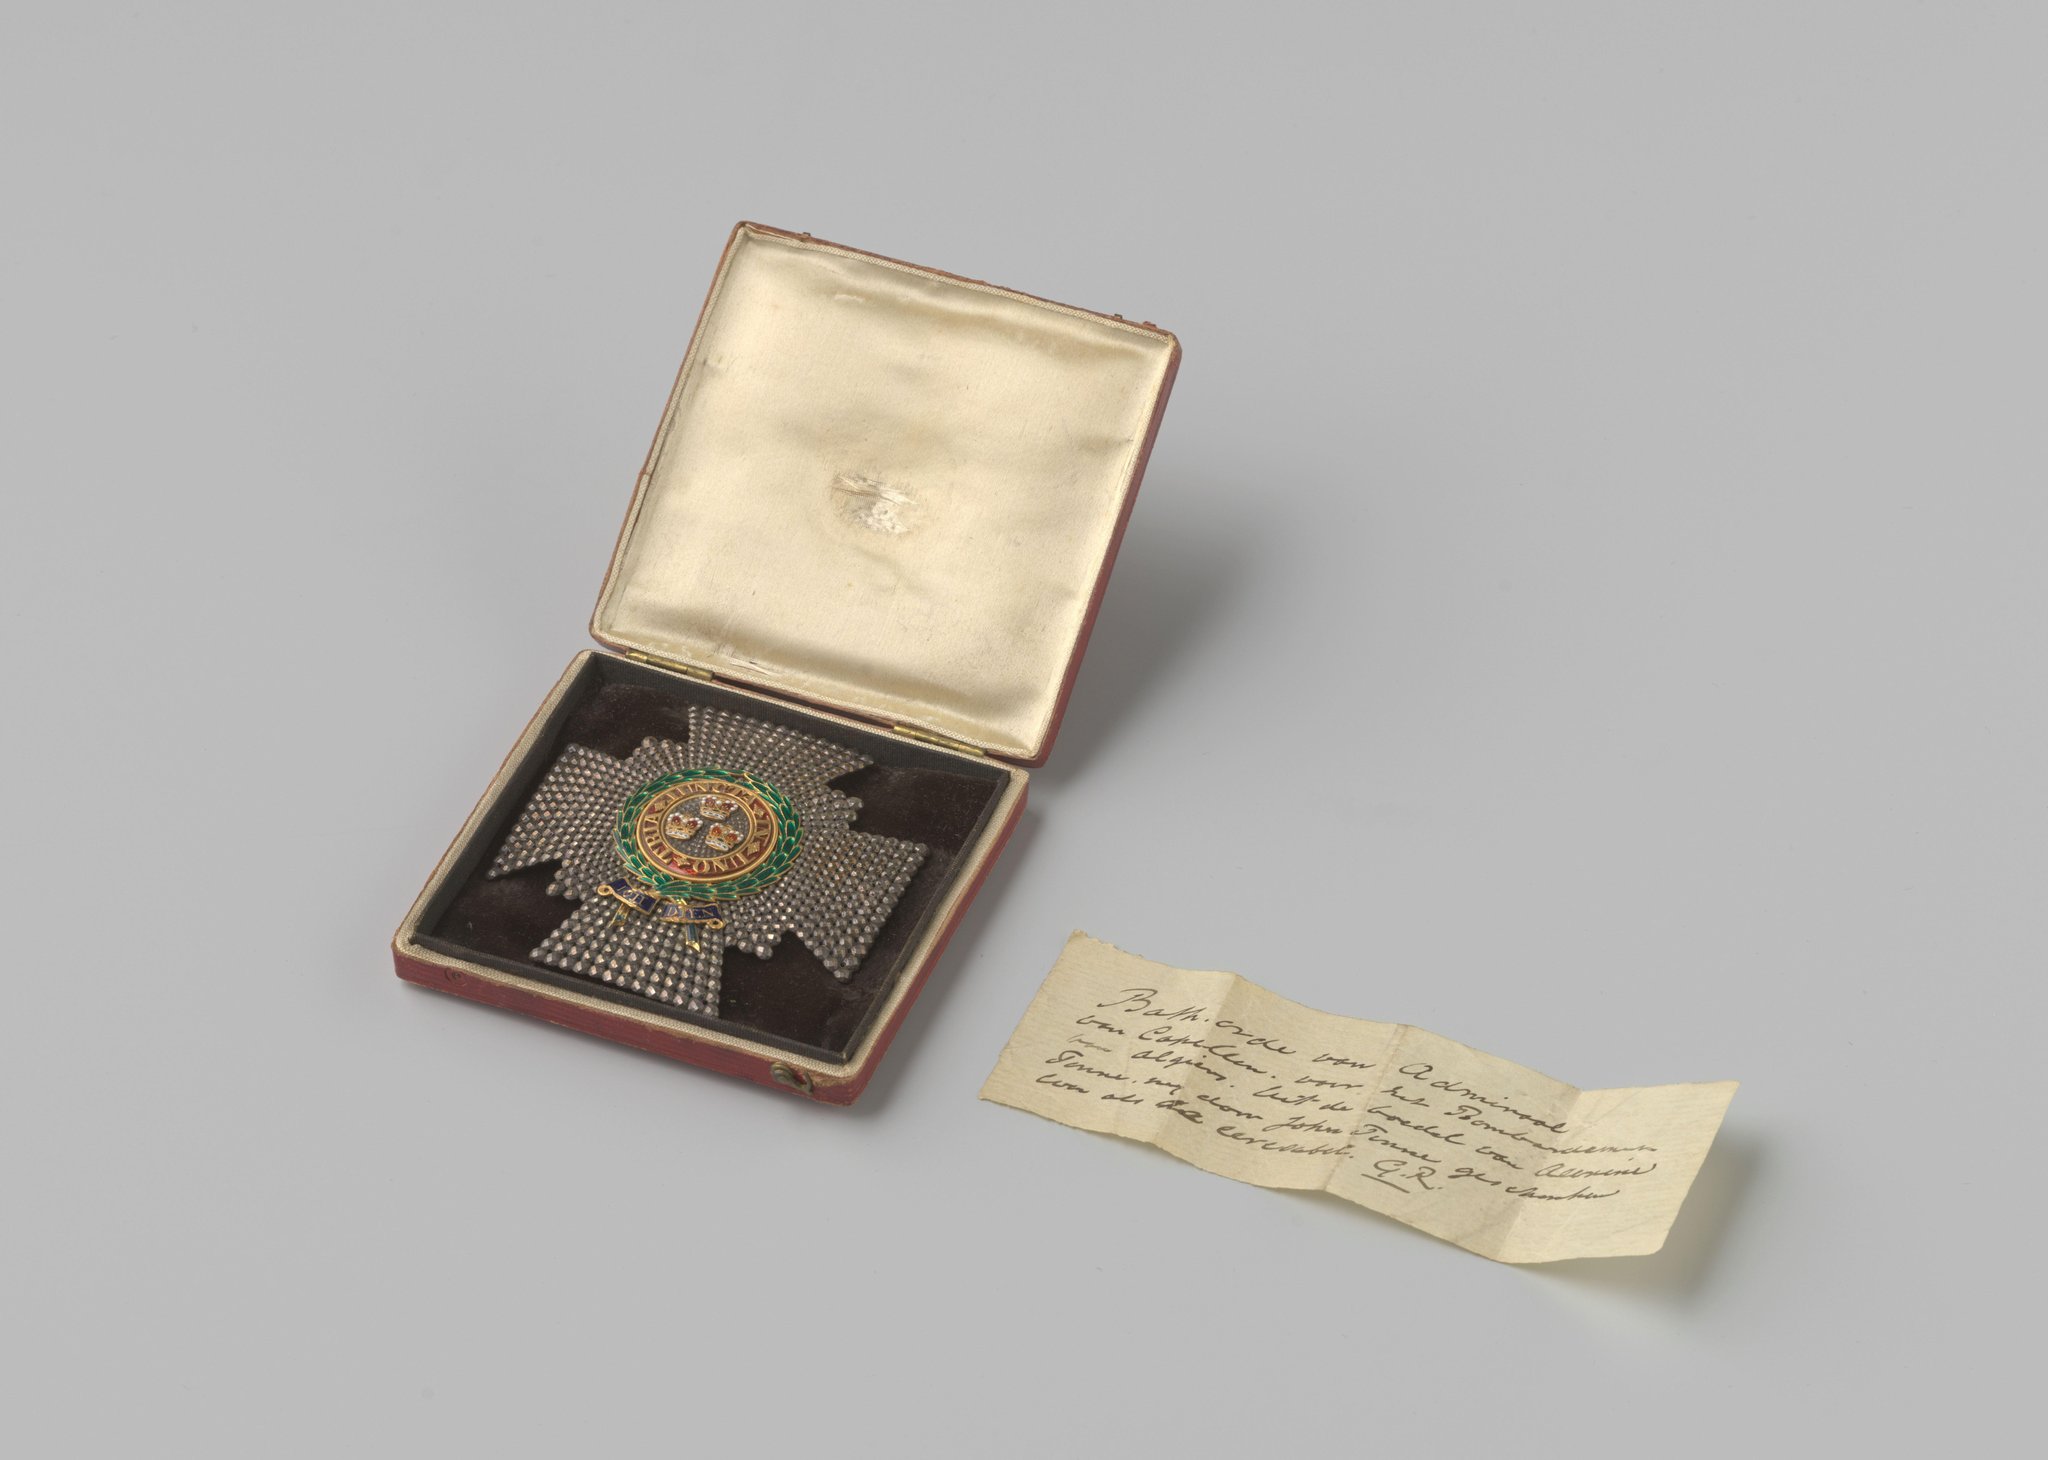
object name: ordeteken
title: Commandeurskruis van de Order of the Bath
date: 1816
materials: copper, steel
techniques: cutting, engraving, polish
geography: england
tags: nijmegen, george iv (koning van het verenigd koninkrijk)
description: Ordeteken in de vorm van een Malthezer kruis met centraal drie in rood, wit en groen geëmailleerde kronen (Engeland, Schotland en Wales) binnen een rood geëmailleerde rand met het omschrift: TRIA JUNCTA IN UNO. Daaromheen een groen geëmailleerde krans van twee takken met aan de onderzijde de blauw geëmailleerde banderolle: "ICH dien". Hierbij een roodleren etui met fluwelen voering. Gesigneerd: Rundell Bridge & Rundell Jewellers to their Majesties His Royal Highness the Prince Regent and the Royal Family.